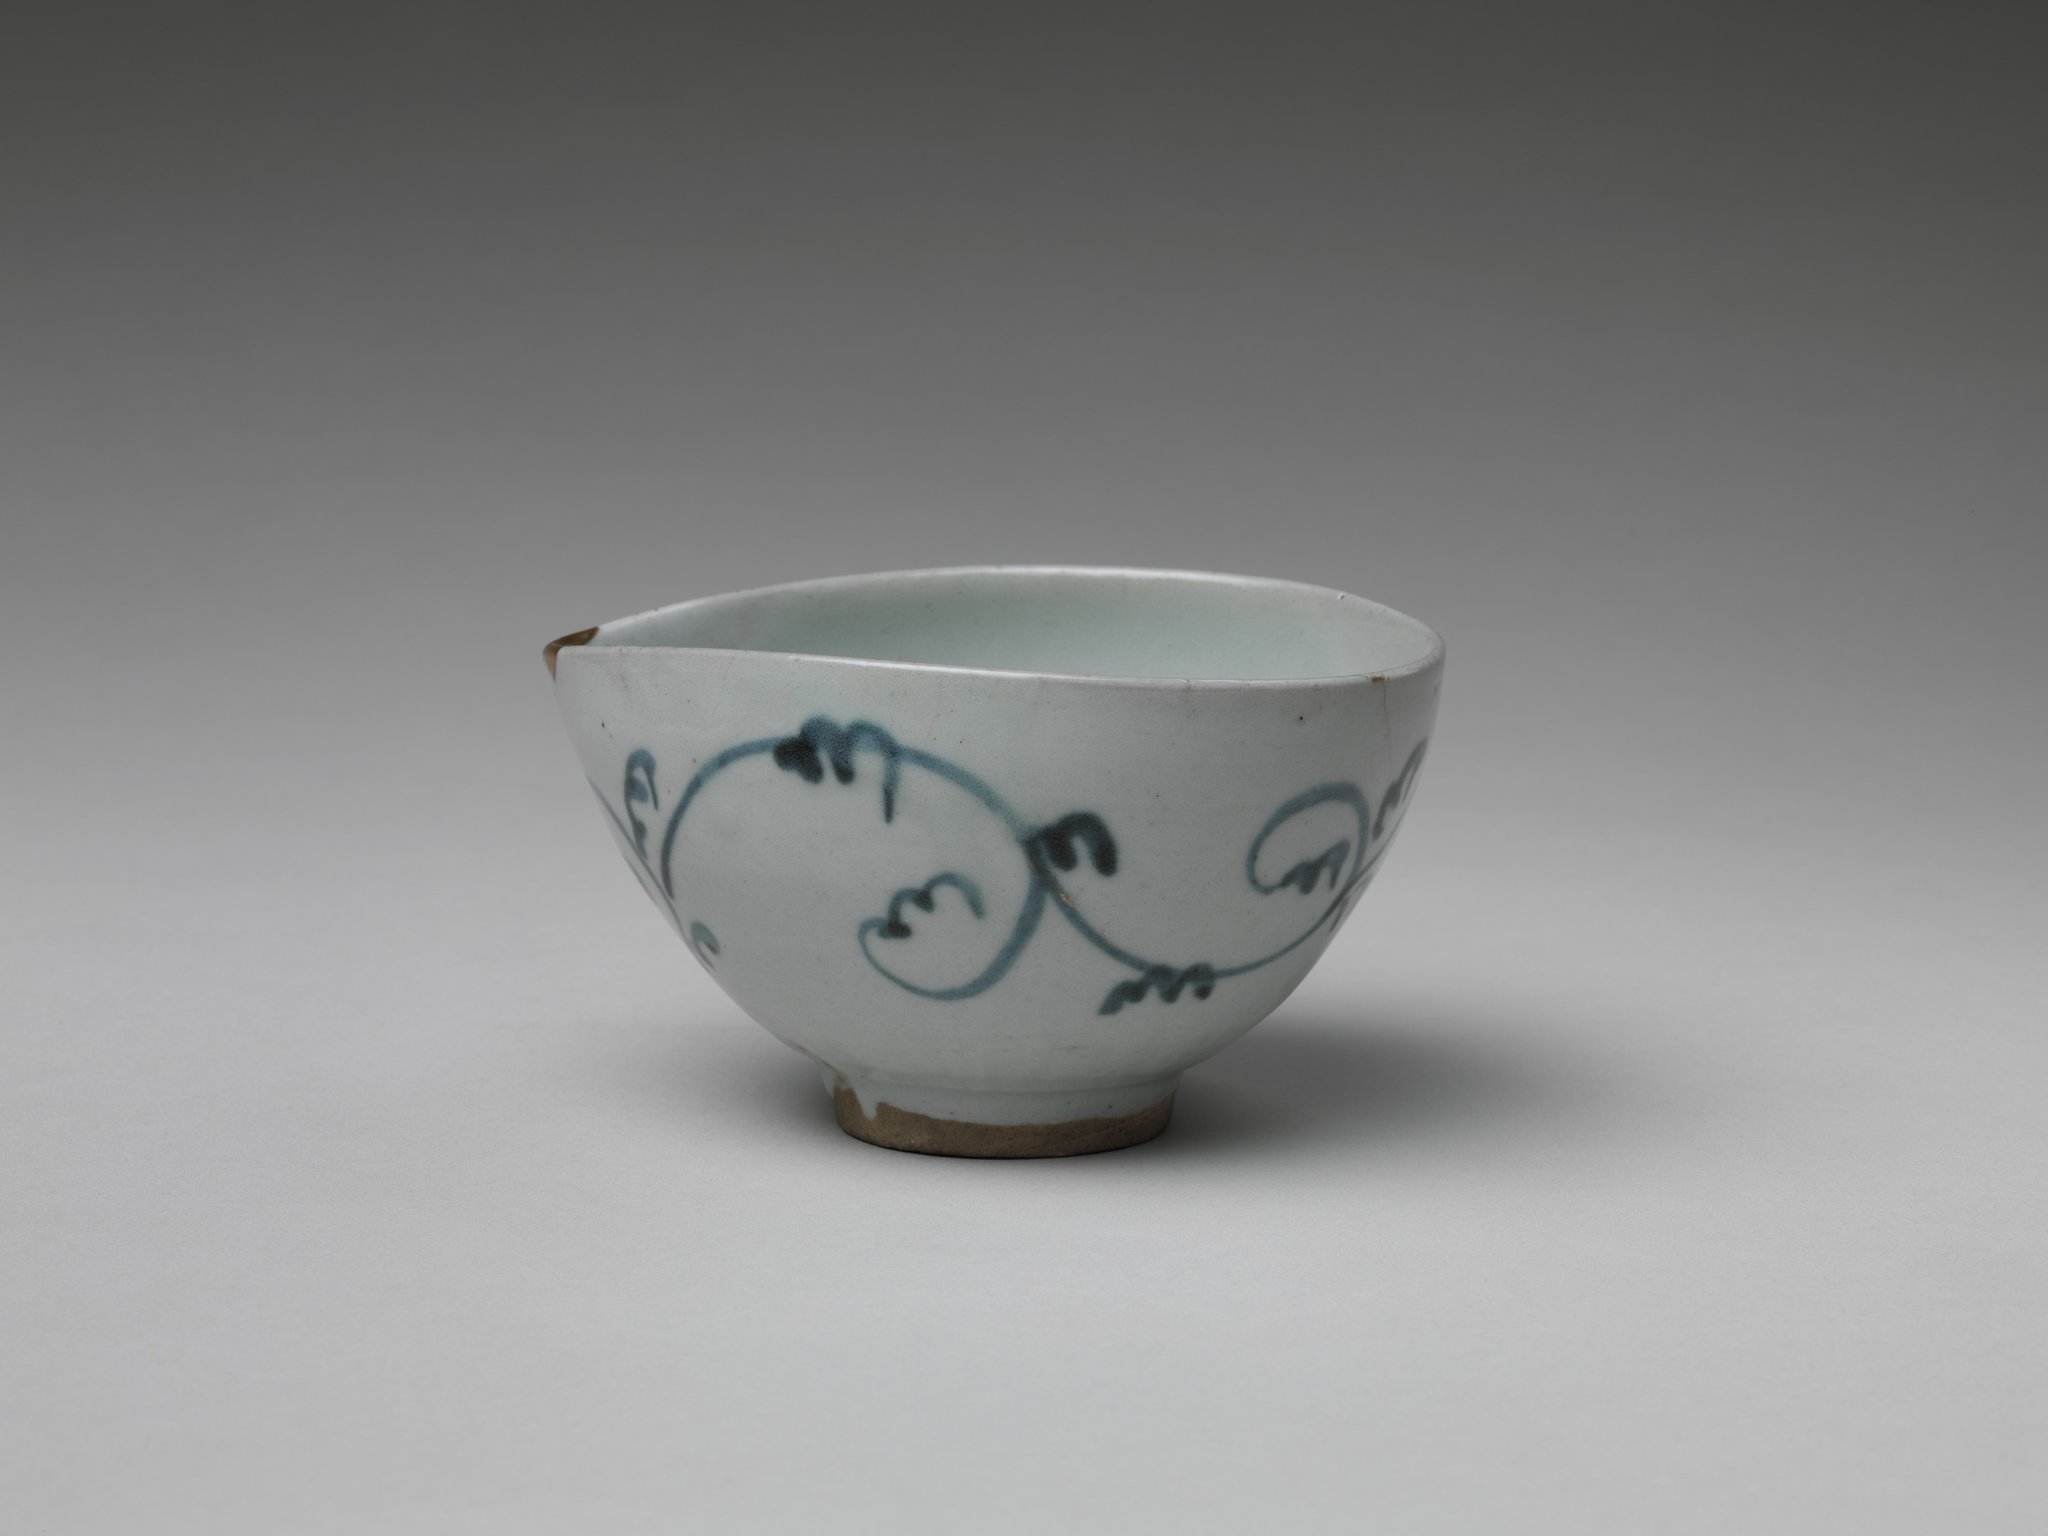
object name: bowl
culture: japanese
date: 1625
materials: porcelain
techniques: underglaze